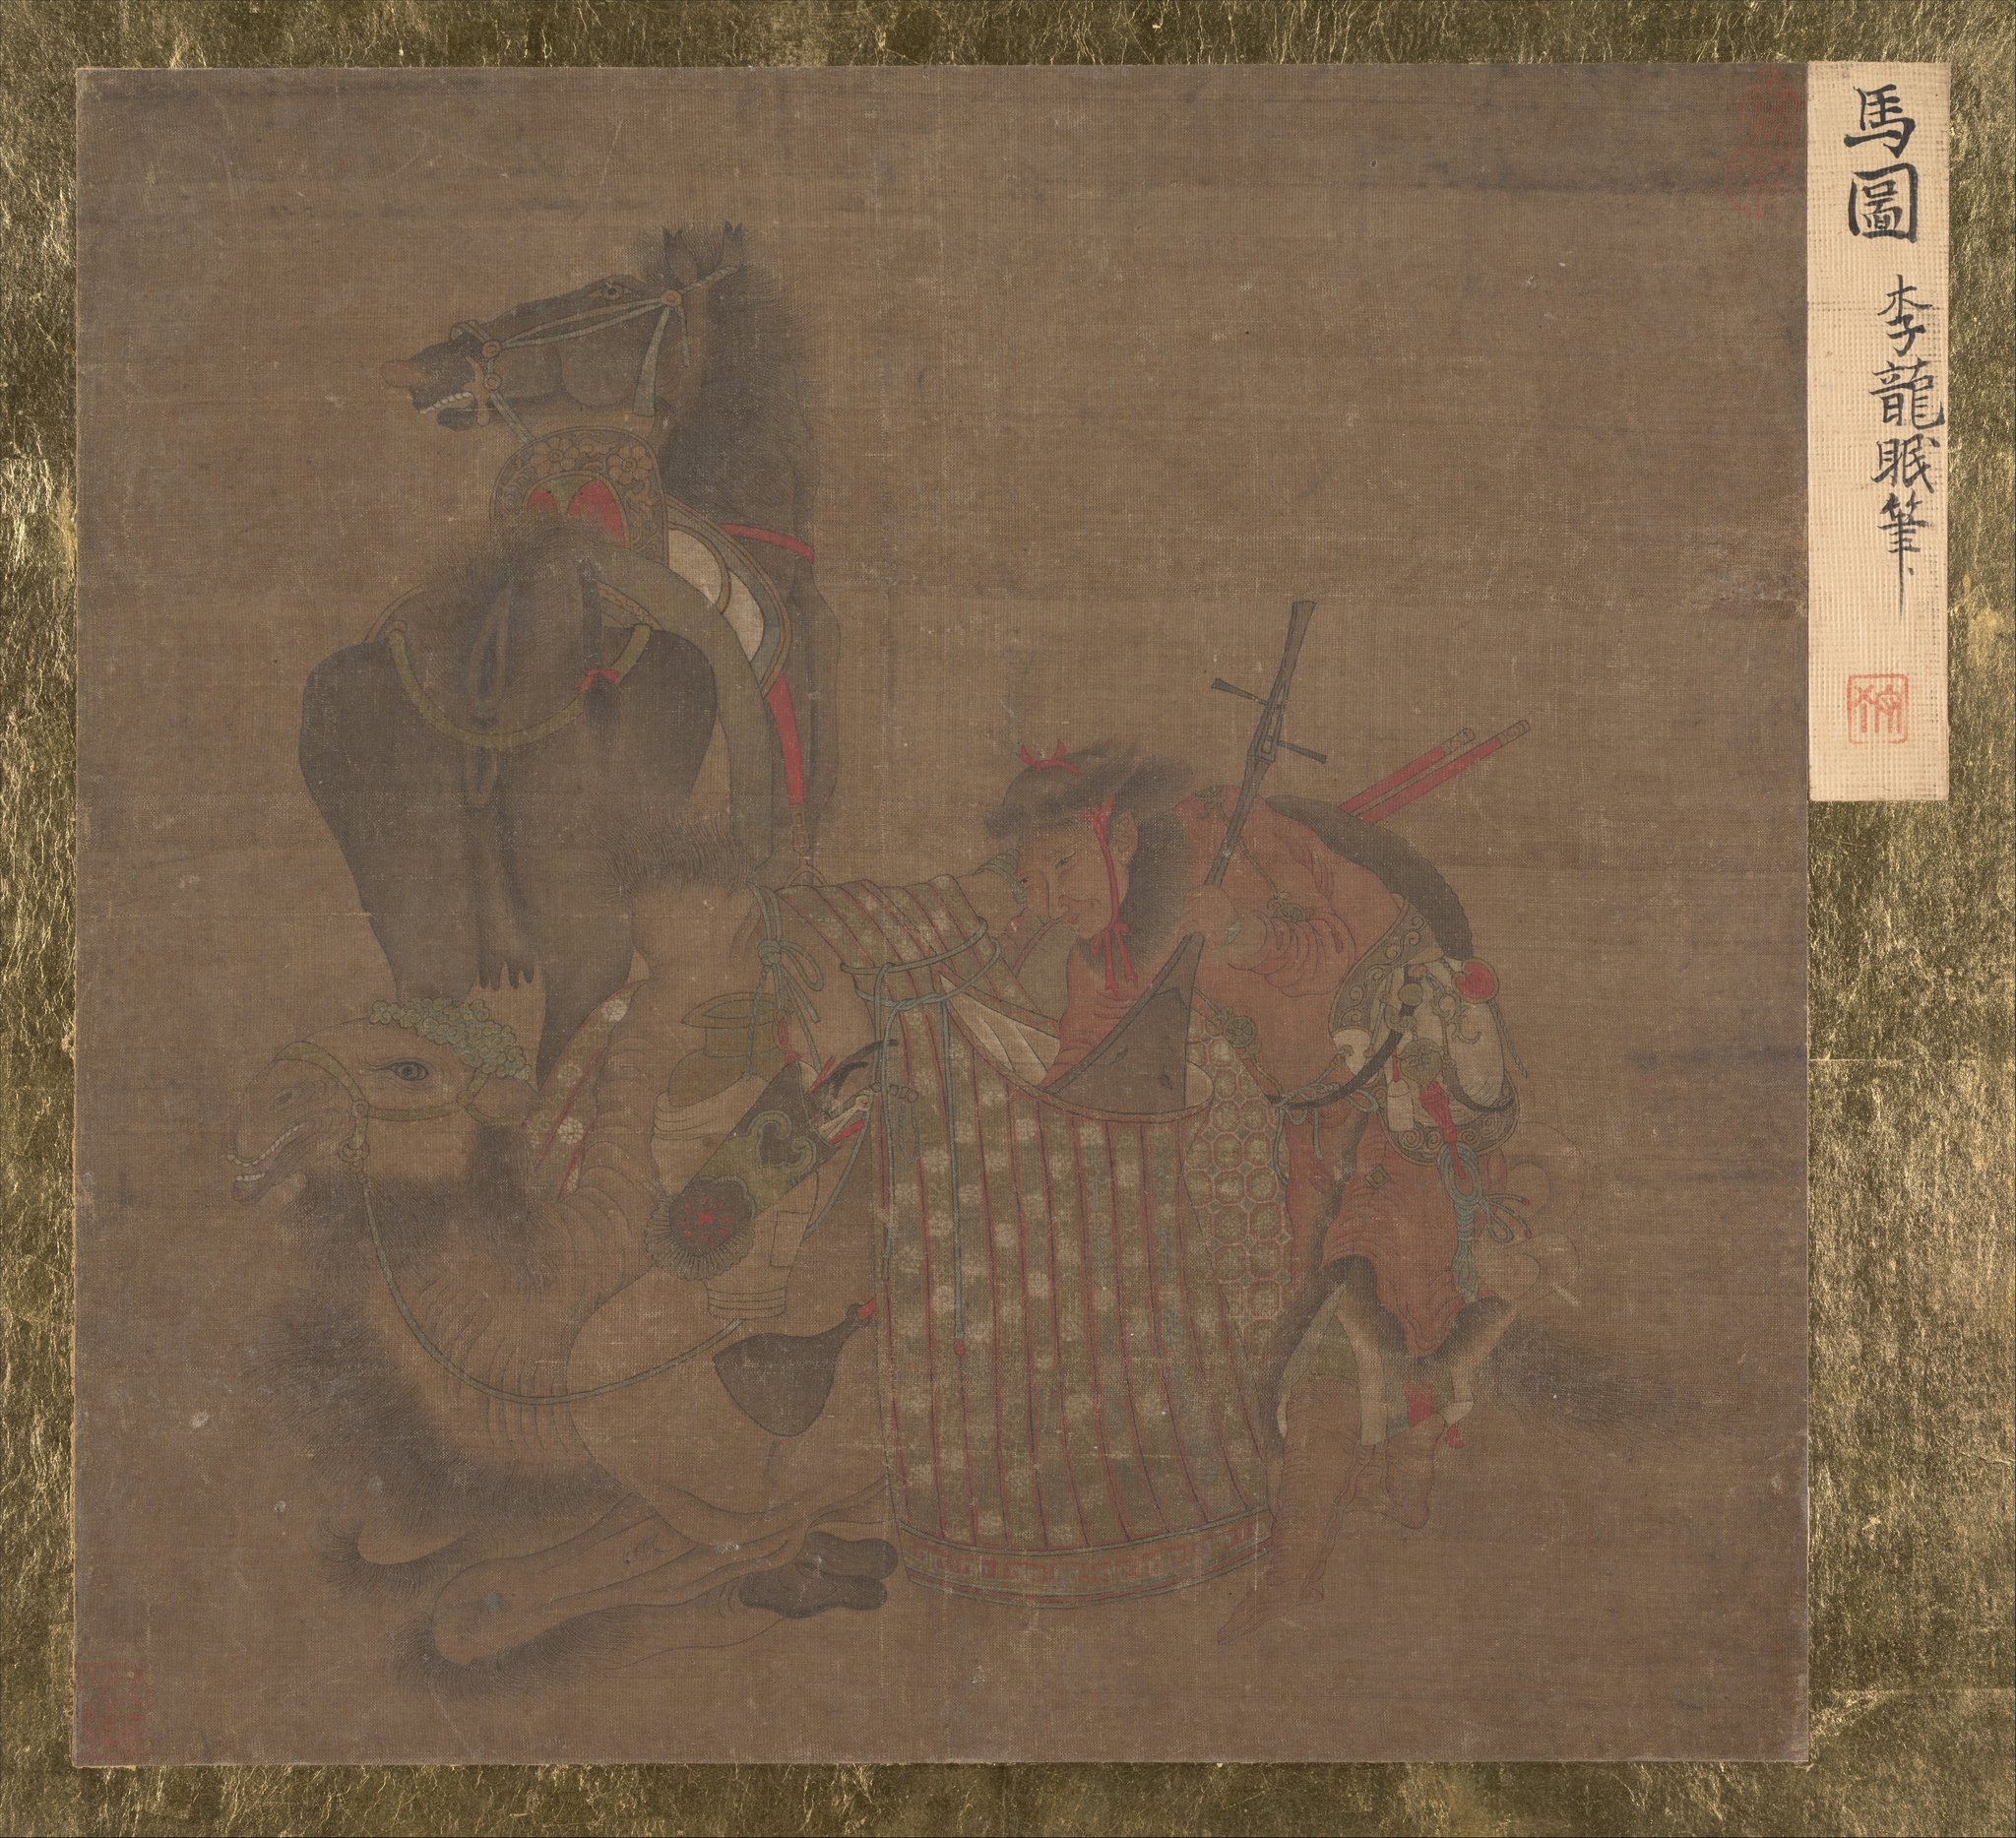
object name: album leaf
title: Mongol with Horse and Camel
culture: chinese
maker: unidentified artist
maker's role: artist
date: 1271-1368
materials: ink, silk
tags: men,camels,horses